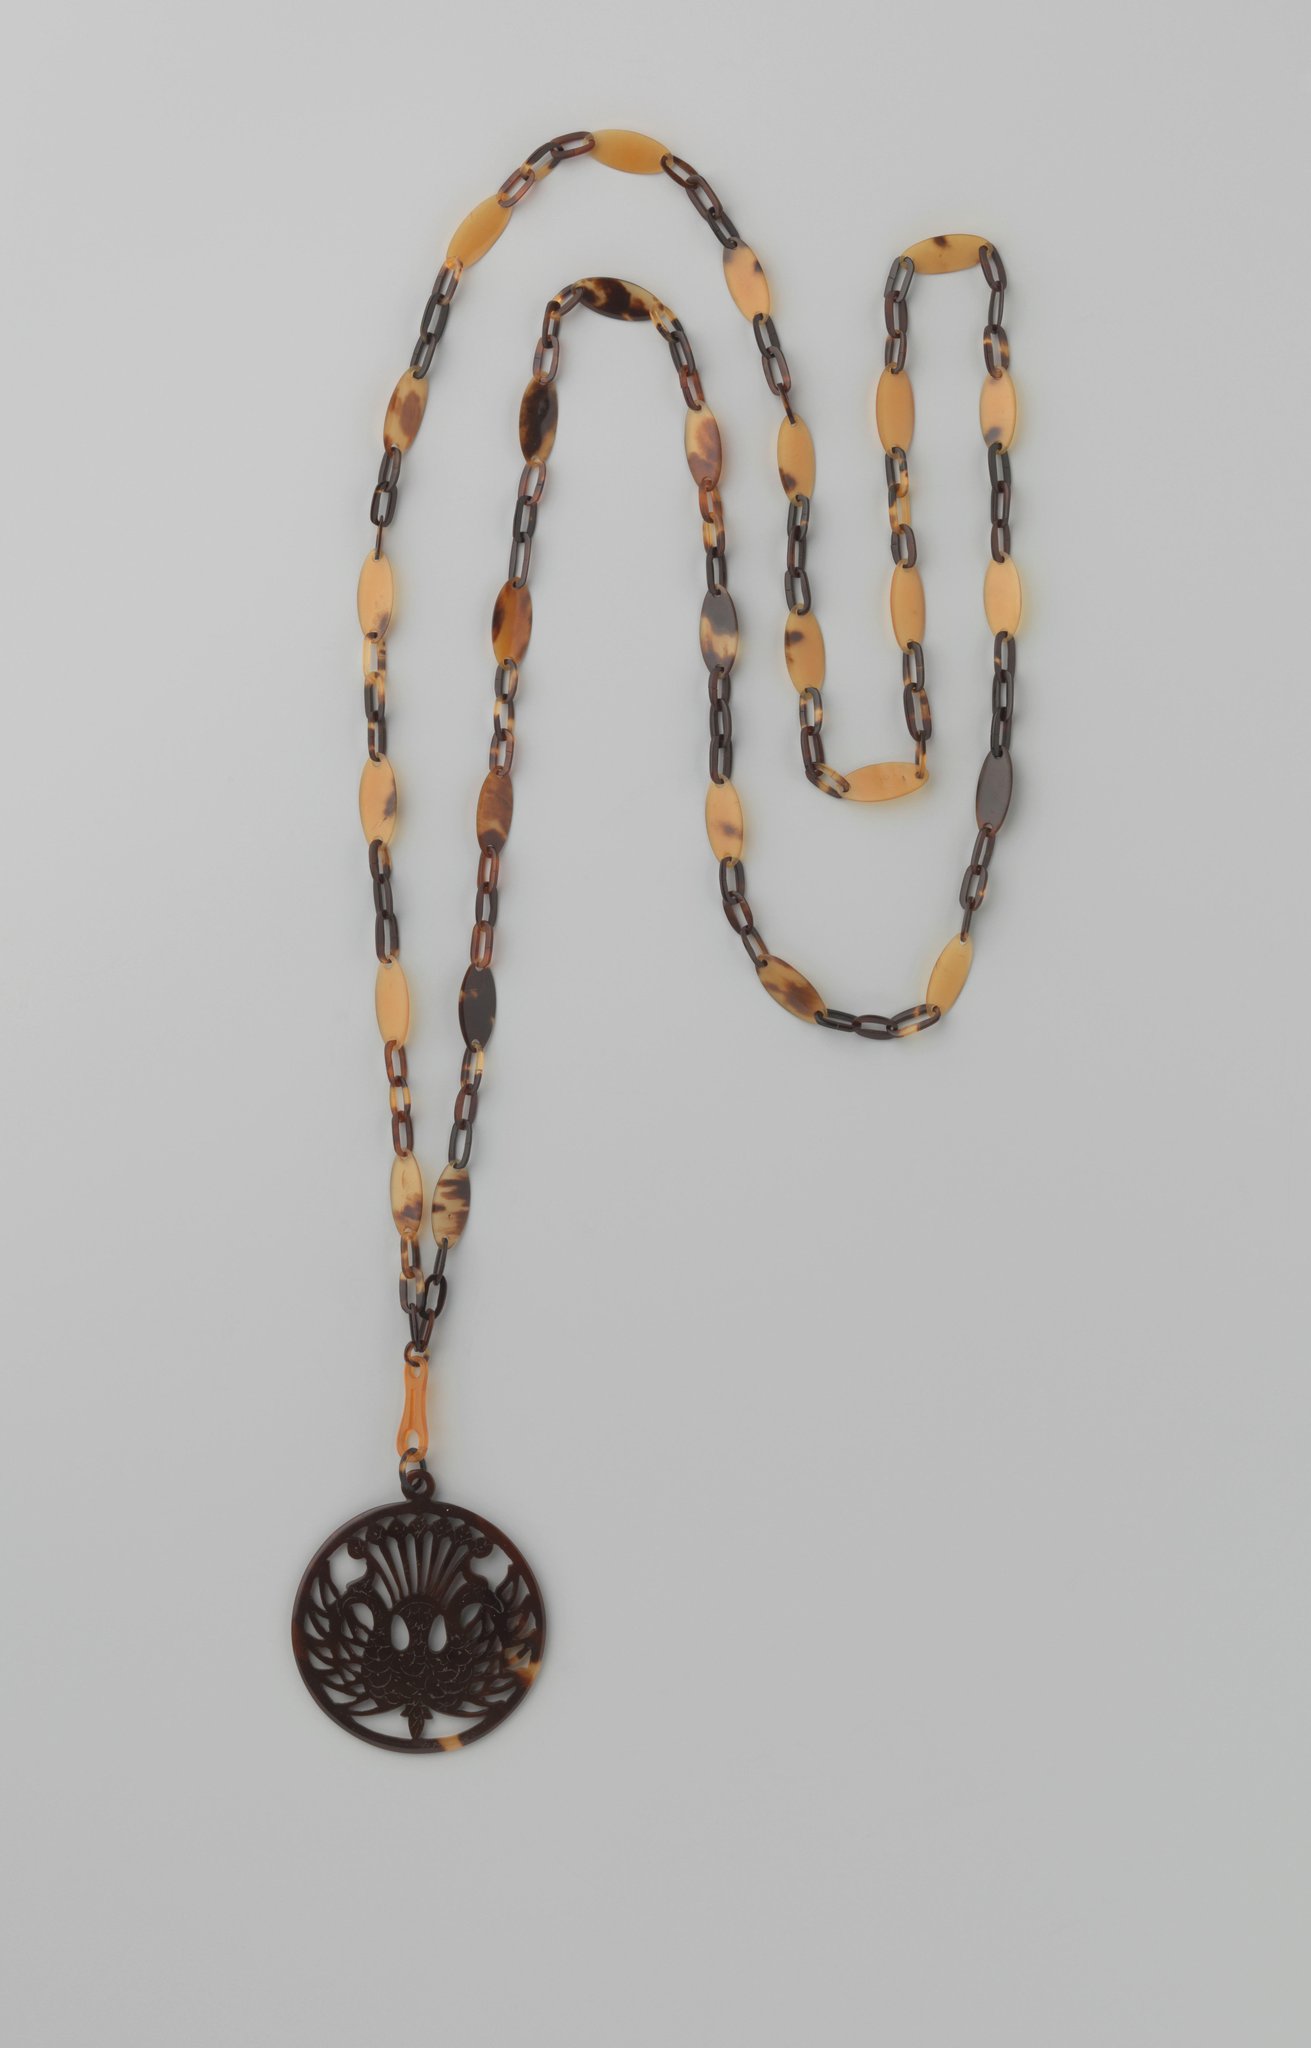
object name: pendant jewelry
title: Collier met hanger van imitatieschildpad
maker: willem van laar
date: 1930-1932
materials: tortoise shell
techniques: cutting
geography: netherlands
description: Collier met ronde opengewerkte hanger van imitatieschildpad. De hanger heeft een gespiegelde pauwendecoratie.